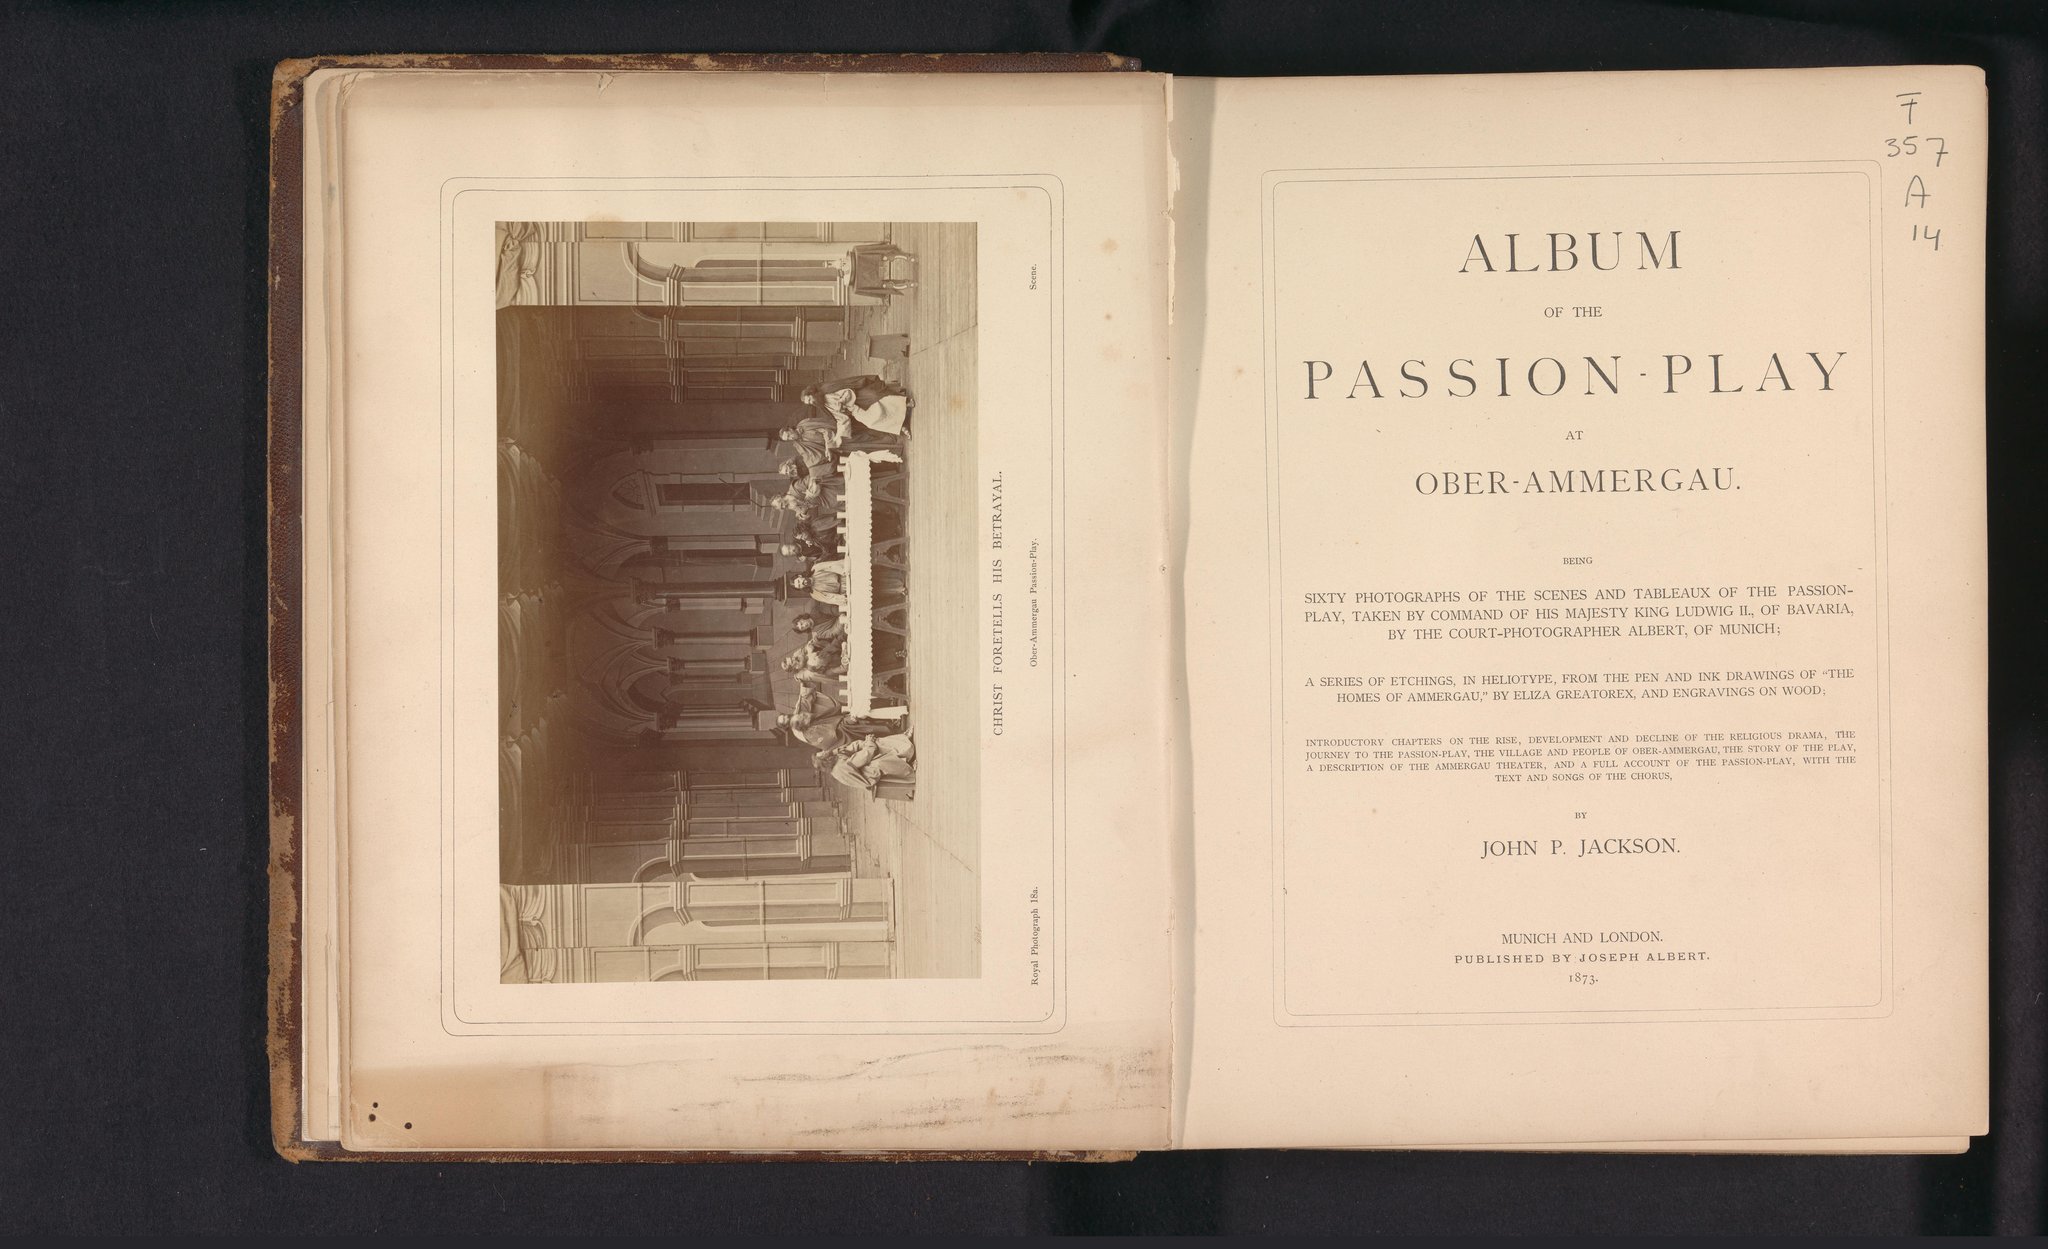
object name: book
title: Album of the passion-play at Ober-Ammergau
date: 1873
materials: cardboard, leather, paper, photographic support, wood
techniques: albumen print, photograph, printing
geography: munich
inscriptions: inscription: ‘7936/A’